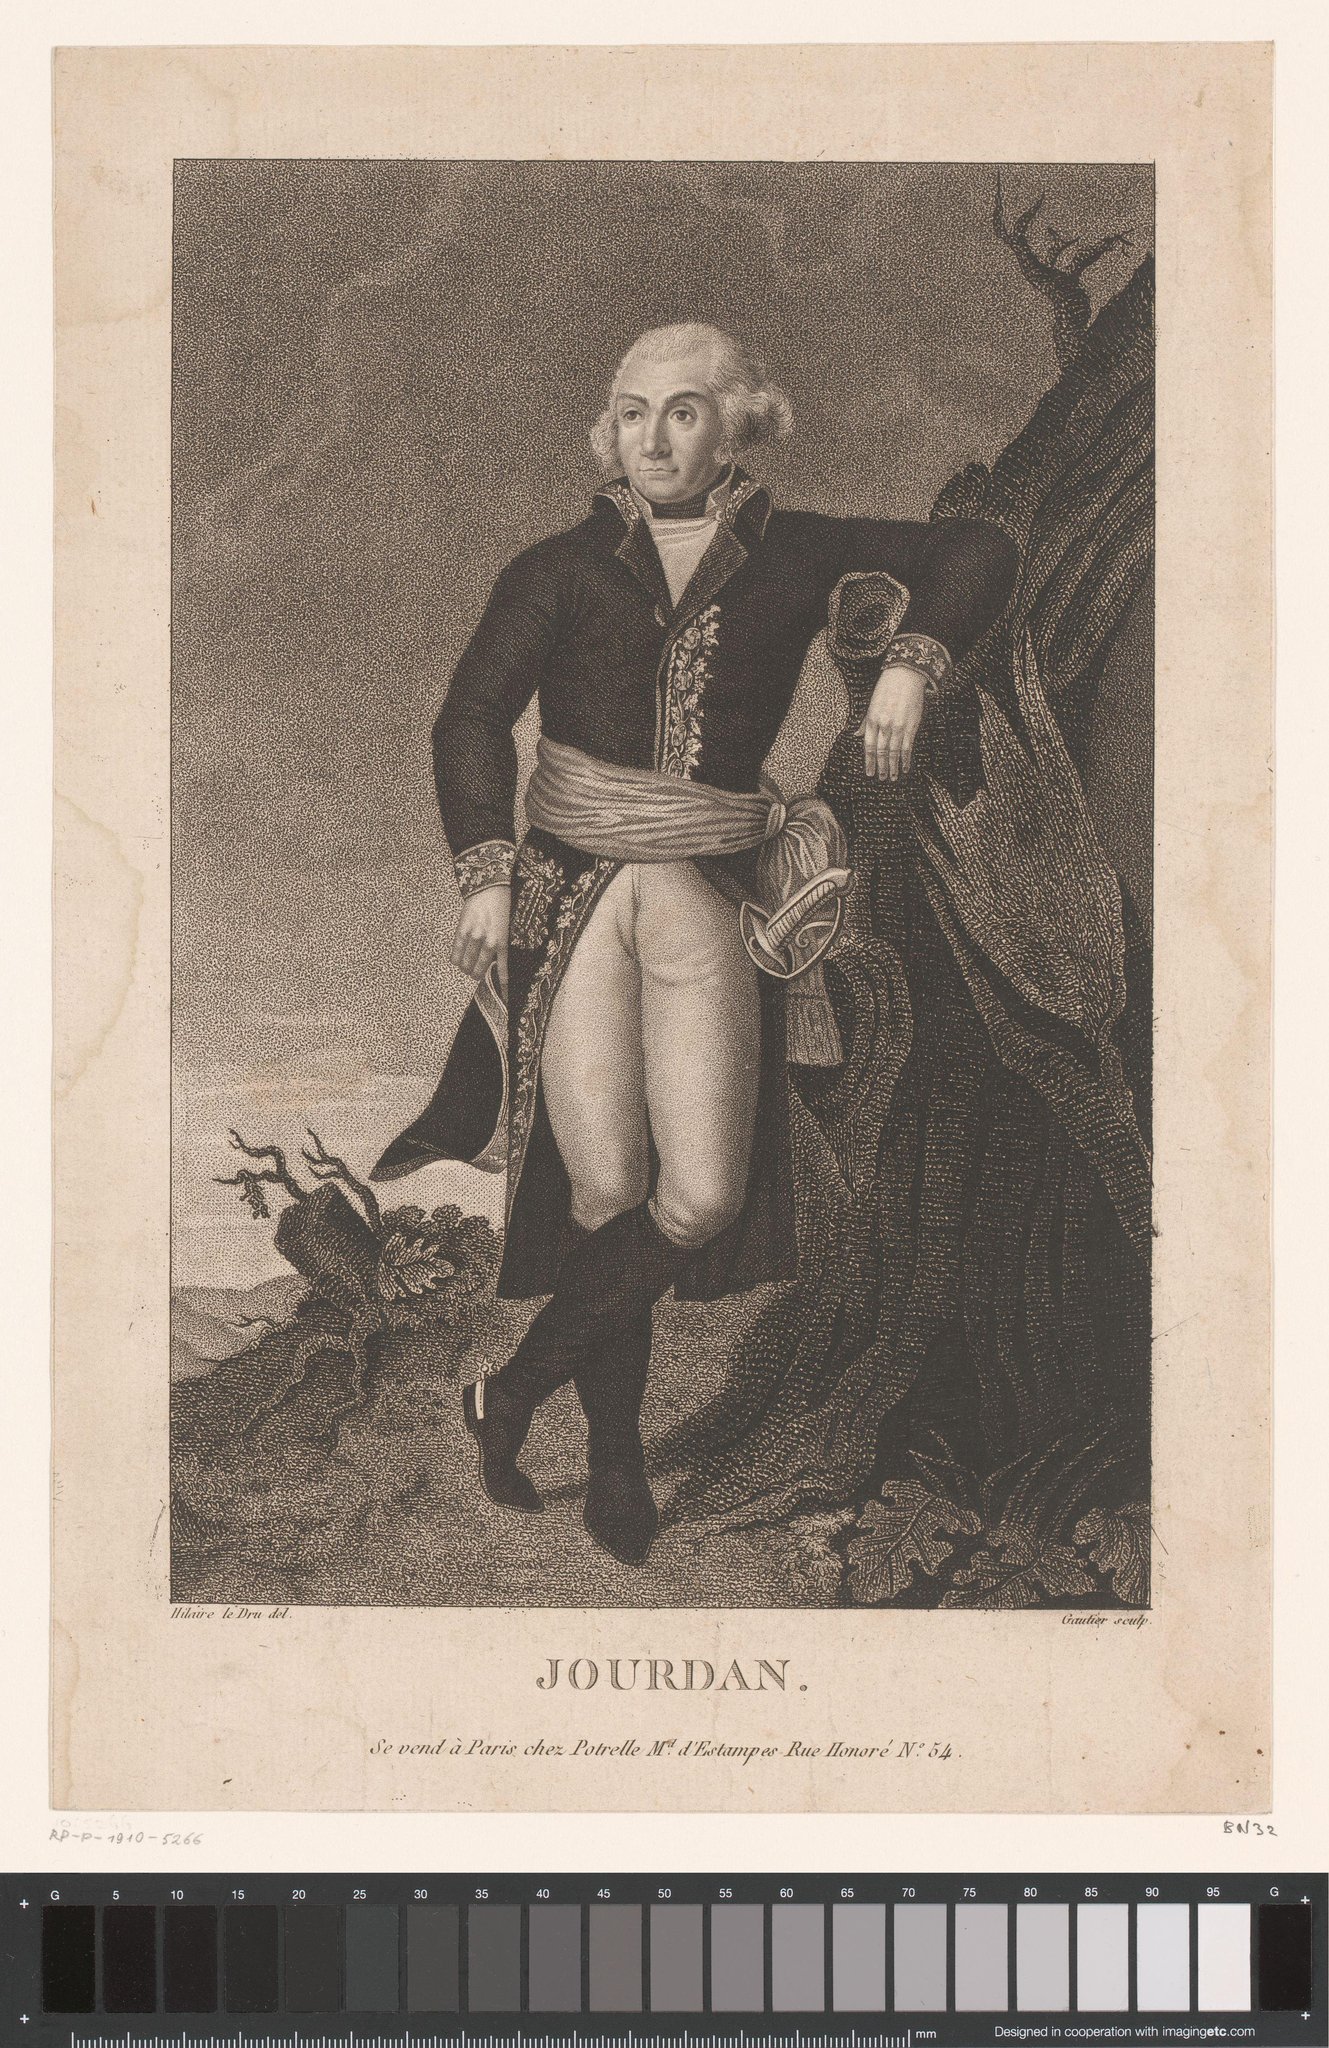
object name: print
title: Jourdan.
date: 1795-1800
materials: paper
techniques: stippling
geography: france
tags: paris, politician, historical persons, standing figure (canon, proportions)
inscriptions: collector's mark: Lugt 2228